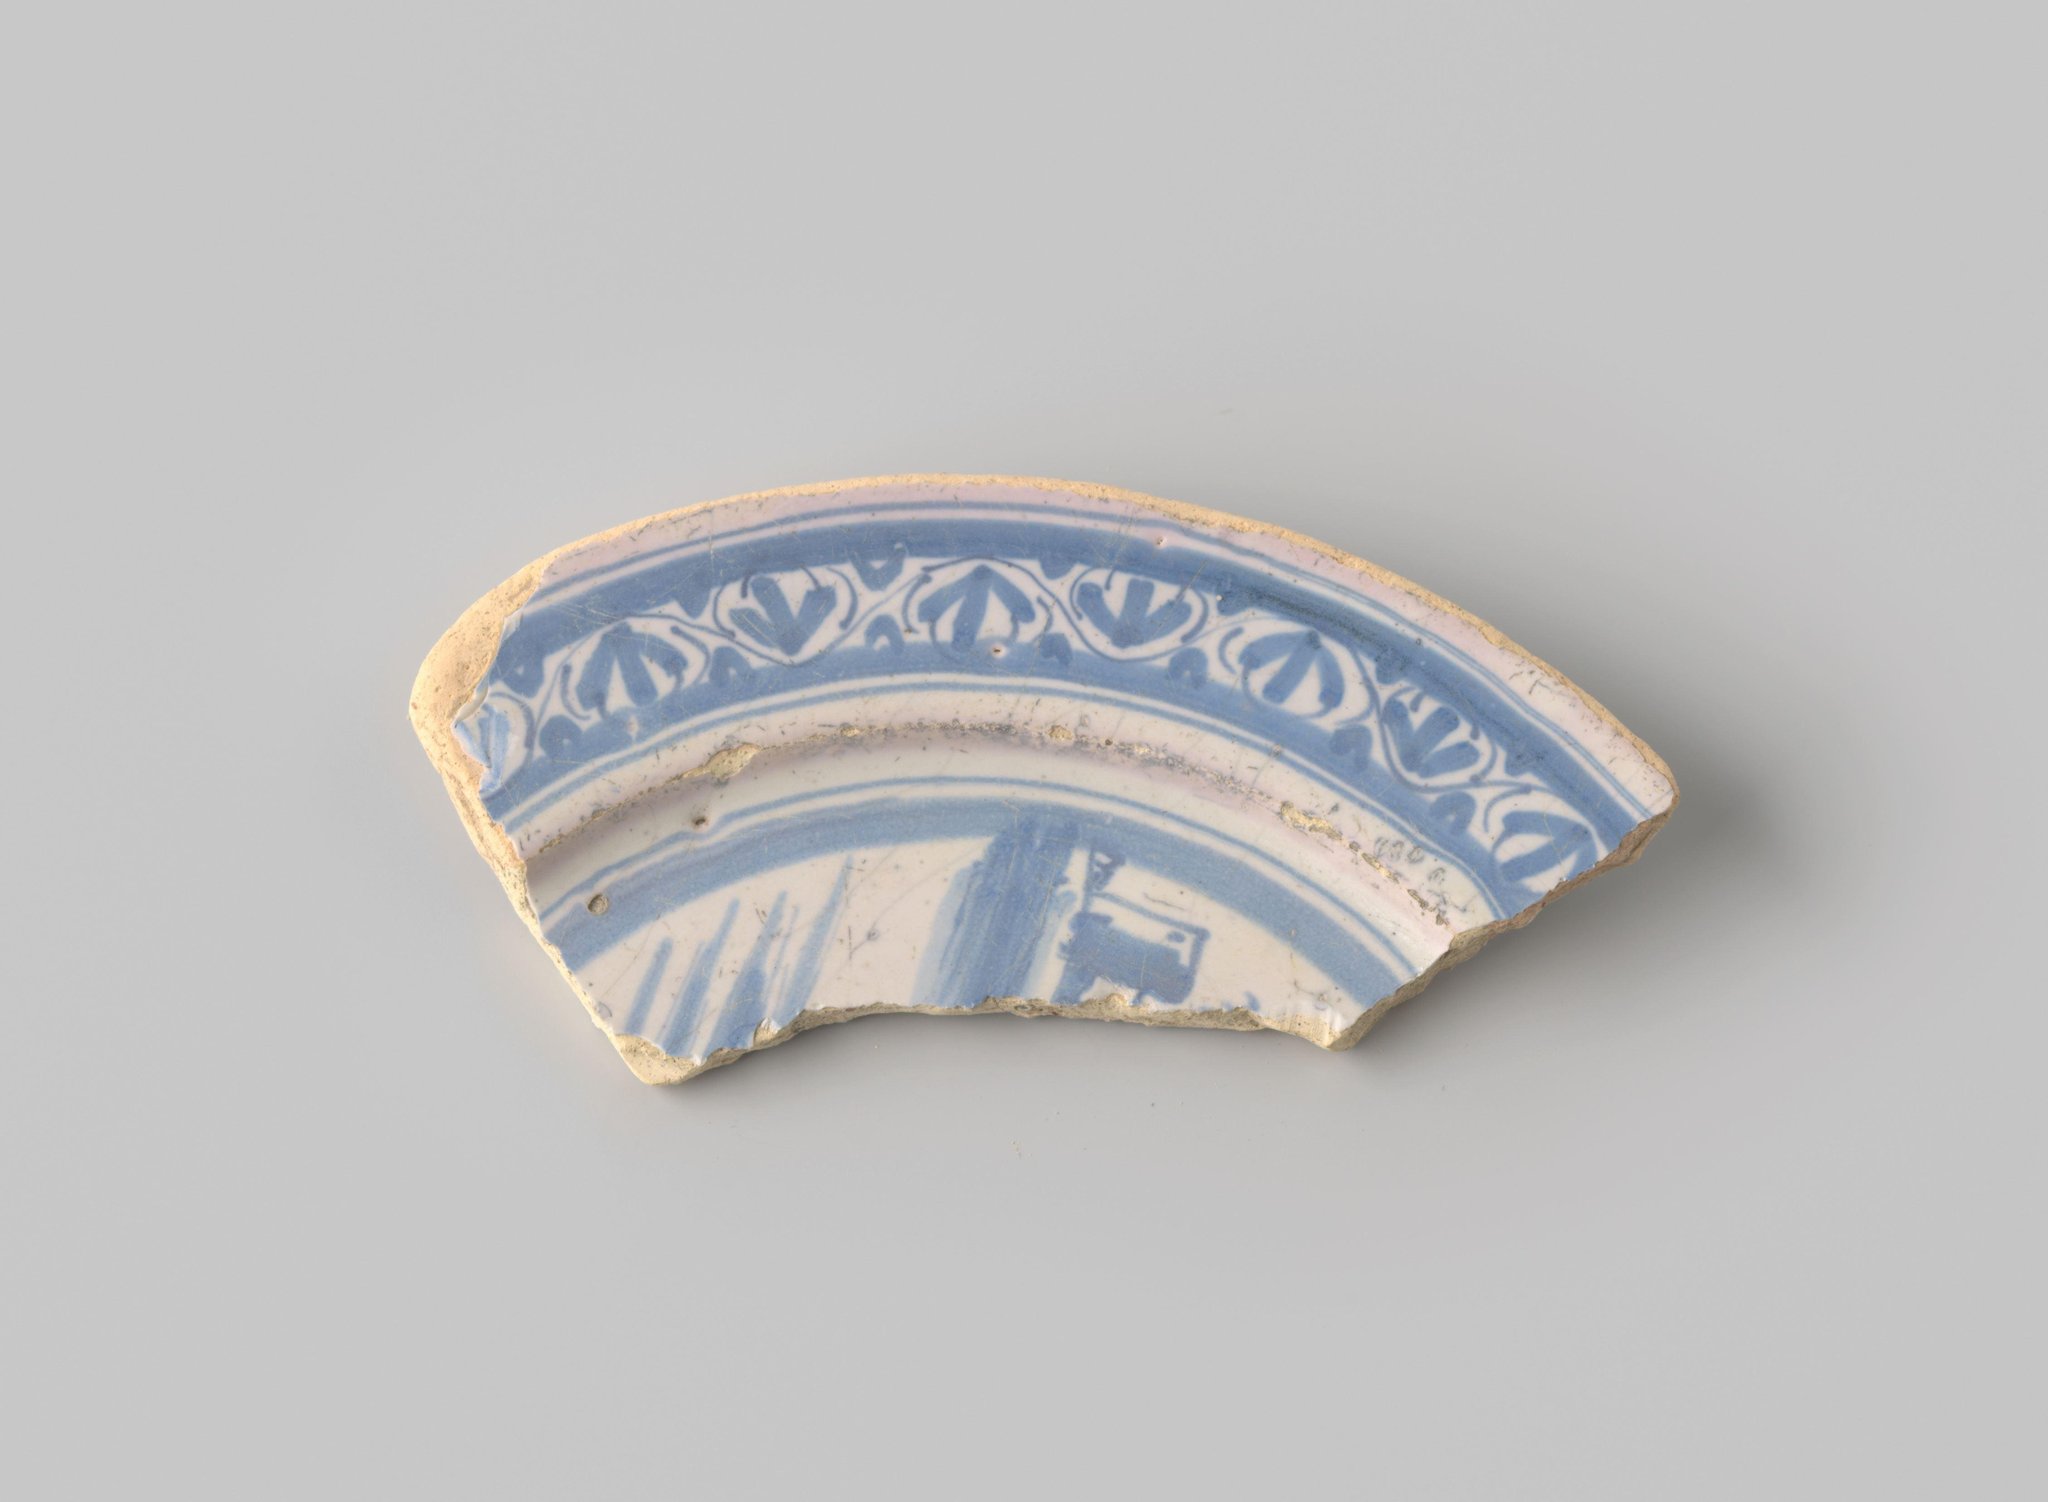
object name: sherd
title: Scherf van gelig bakkend aardewerk, voorzien van wit glazuur, aan de voorzijde voorzien van een sierrand en een deel van een landschap in blauw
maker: Anonymous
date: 1600-1650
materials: earthenware, glaze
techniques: maiolica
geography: northern netherlands